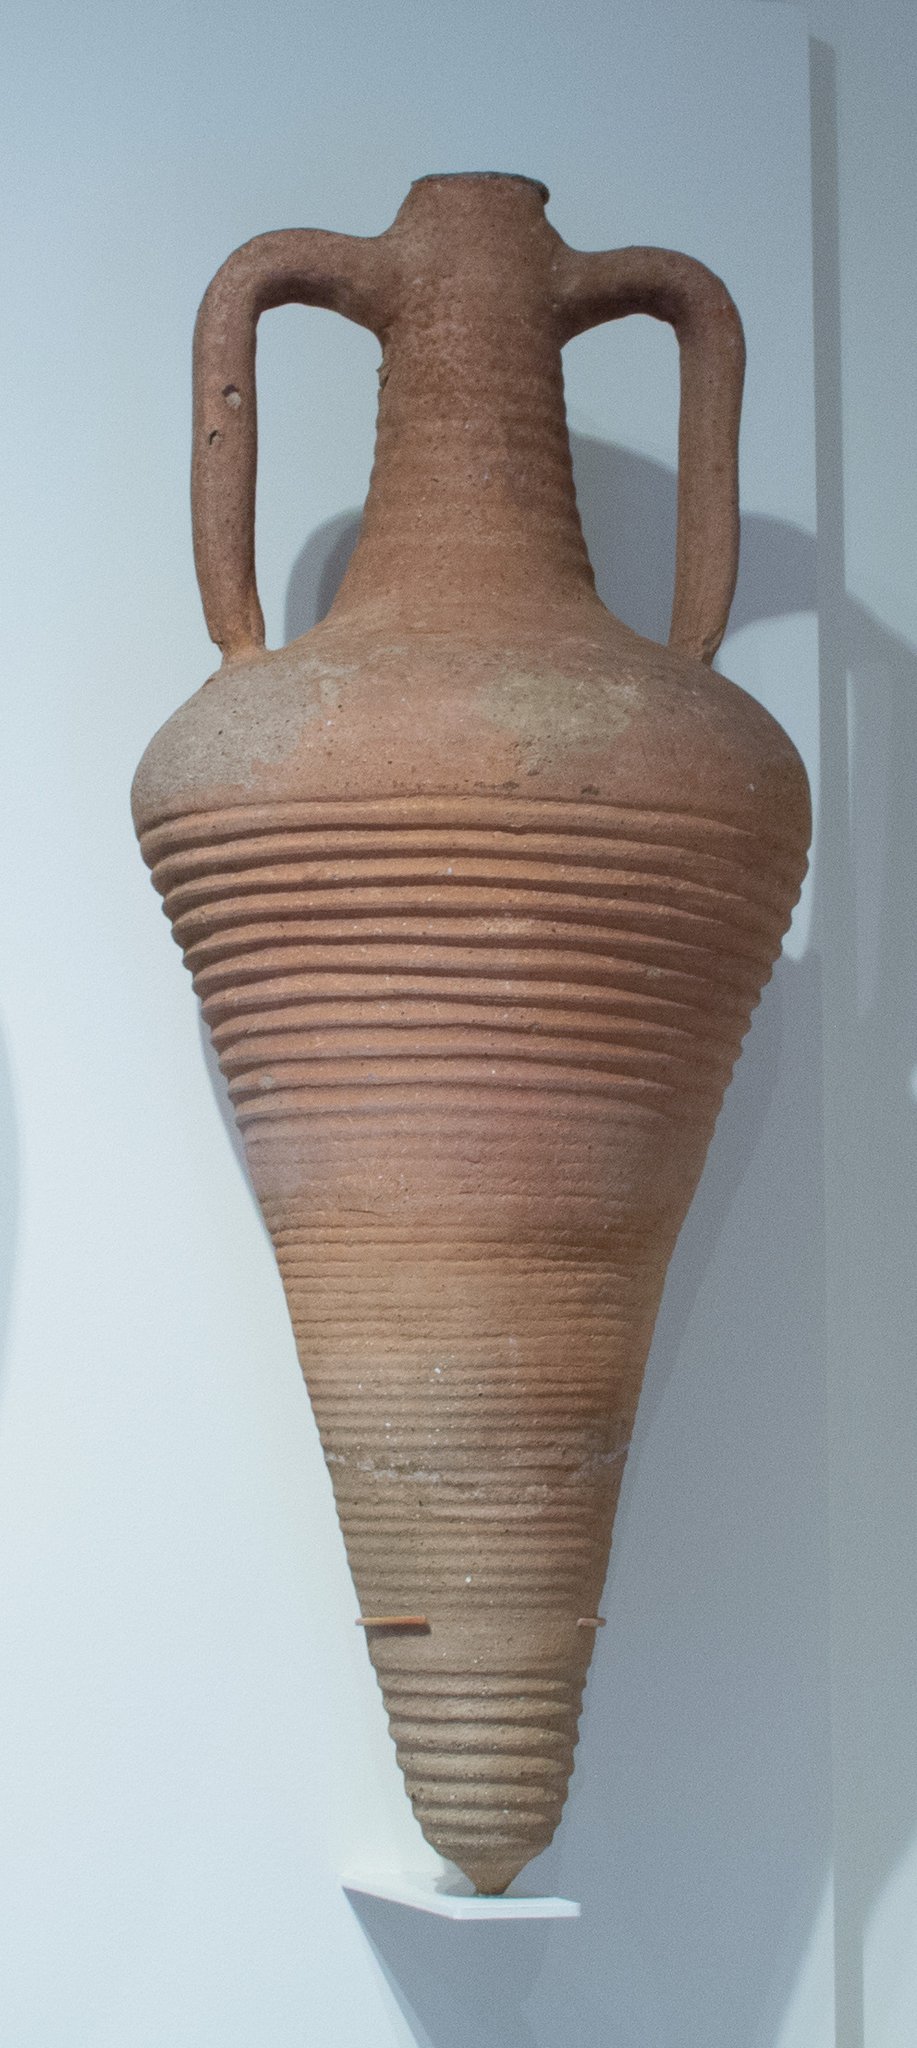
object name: amphora, pointed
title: Terracotta transport amphora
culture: roman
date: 201-233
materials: terracotta